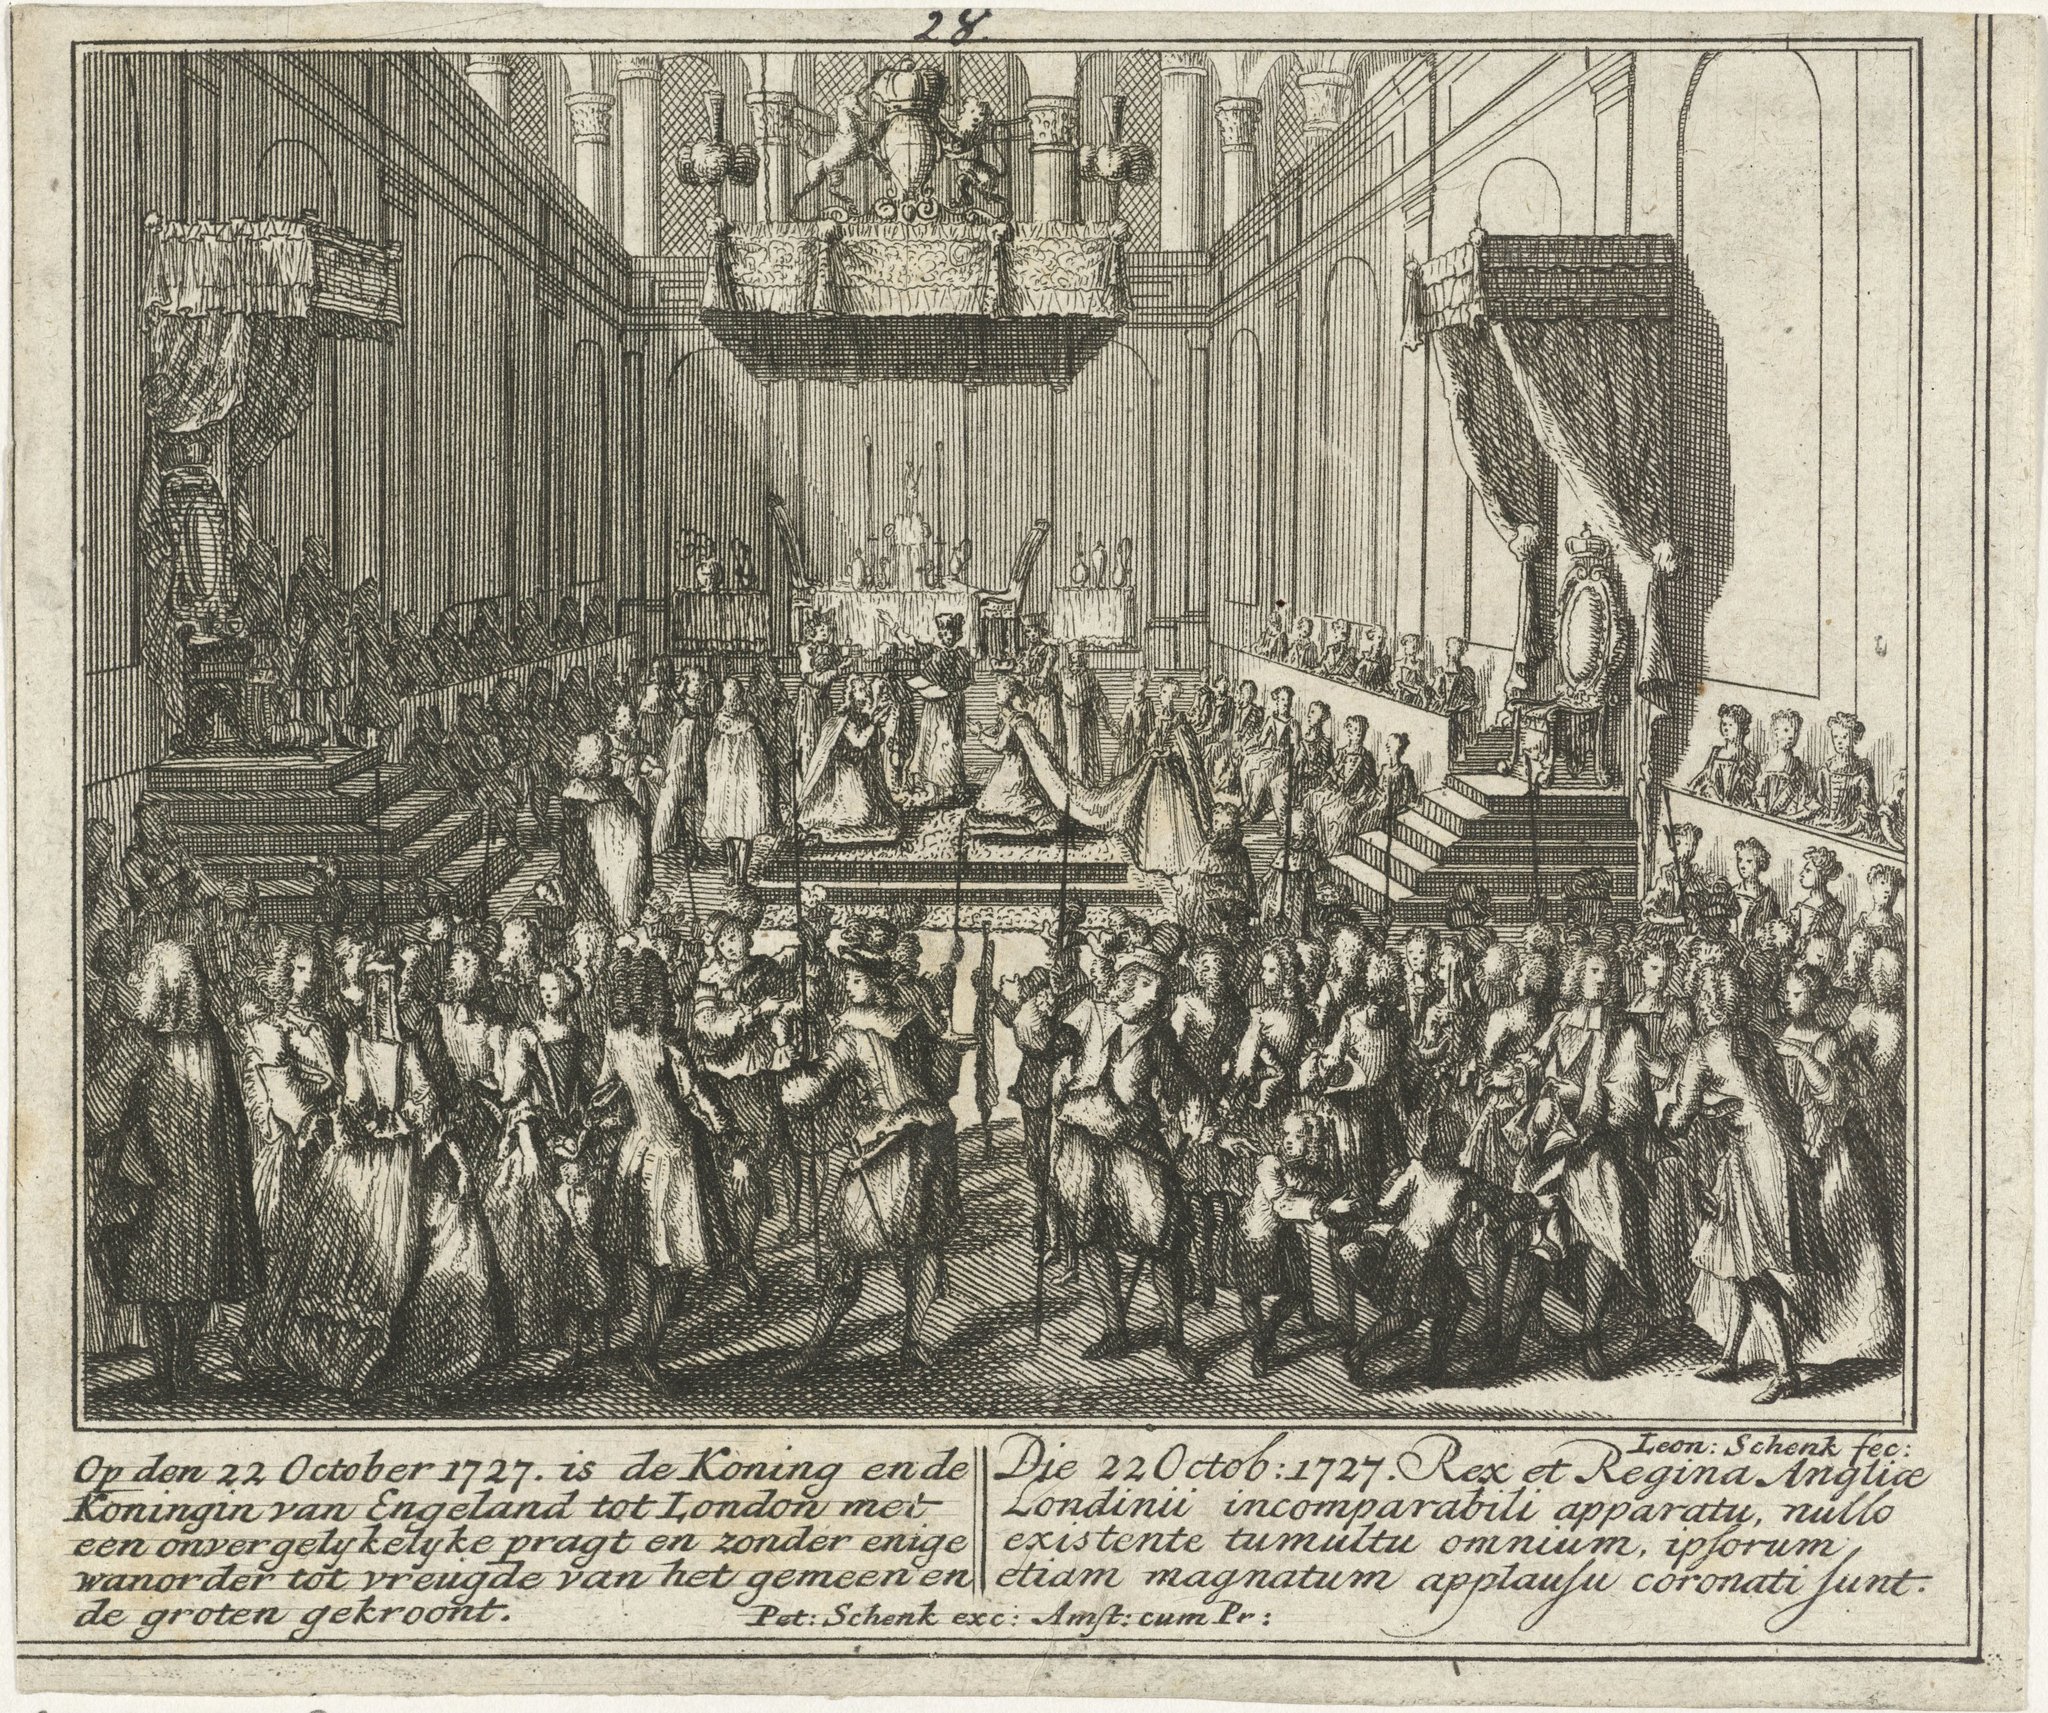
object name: print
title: Op den 22 October 1727 is de Koning en de Koningin van Engeland tot London met een onvergetelyke pragt en zonder enige wanorder tot vreugde van het gemeen en de groten gekroont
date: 1727-1729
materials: paper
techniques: etching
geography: amsterdam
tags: london, george ii augustus (koning van groot-brittannië), coronation of a ruler, westminster abbey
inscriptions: number: ‘28’, collector's mark: Lugt 2228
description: Kroning van George II, koning van Engeland, en zijn gemalin in de Westminster Abbey te Londen, 11 of 22 oktober 1727. Met onderschriften in het Nederlands en Frans. Fragment van een grote plaat met negen voorstellingen van gebeurtenissen uit het jaar 1727.